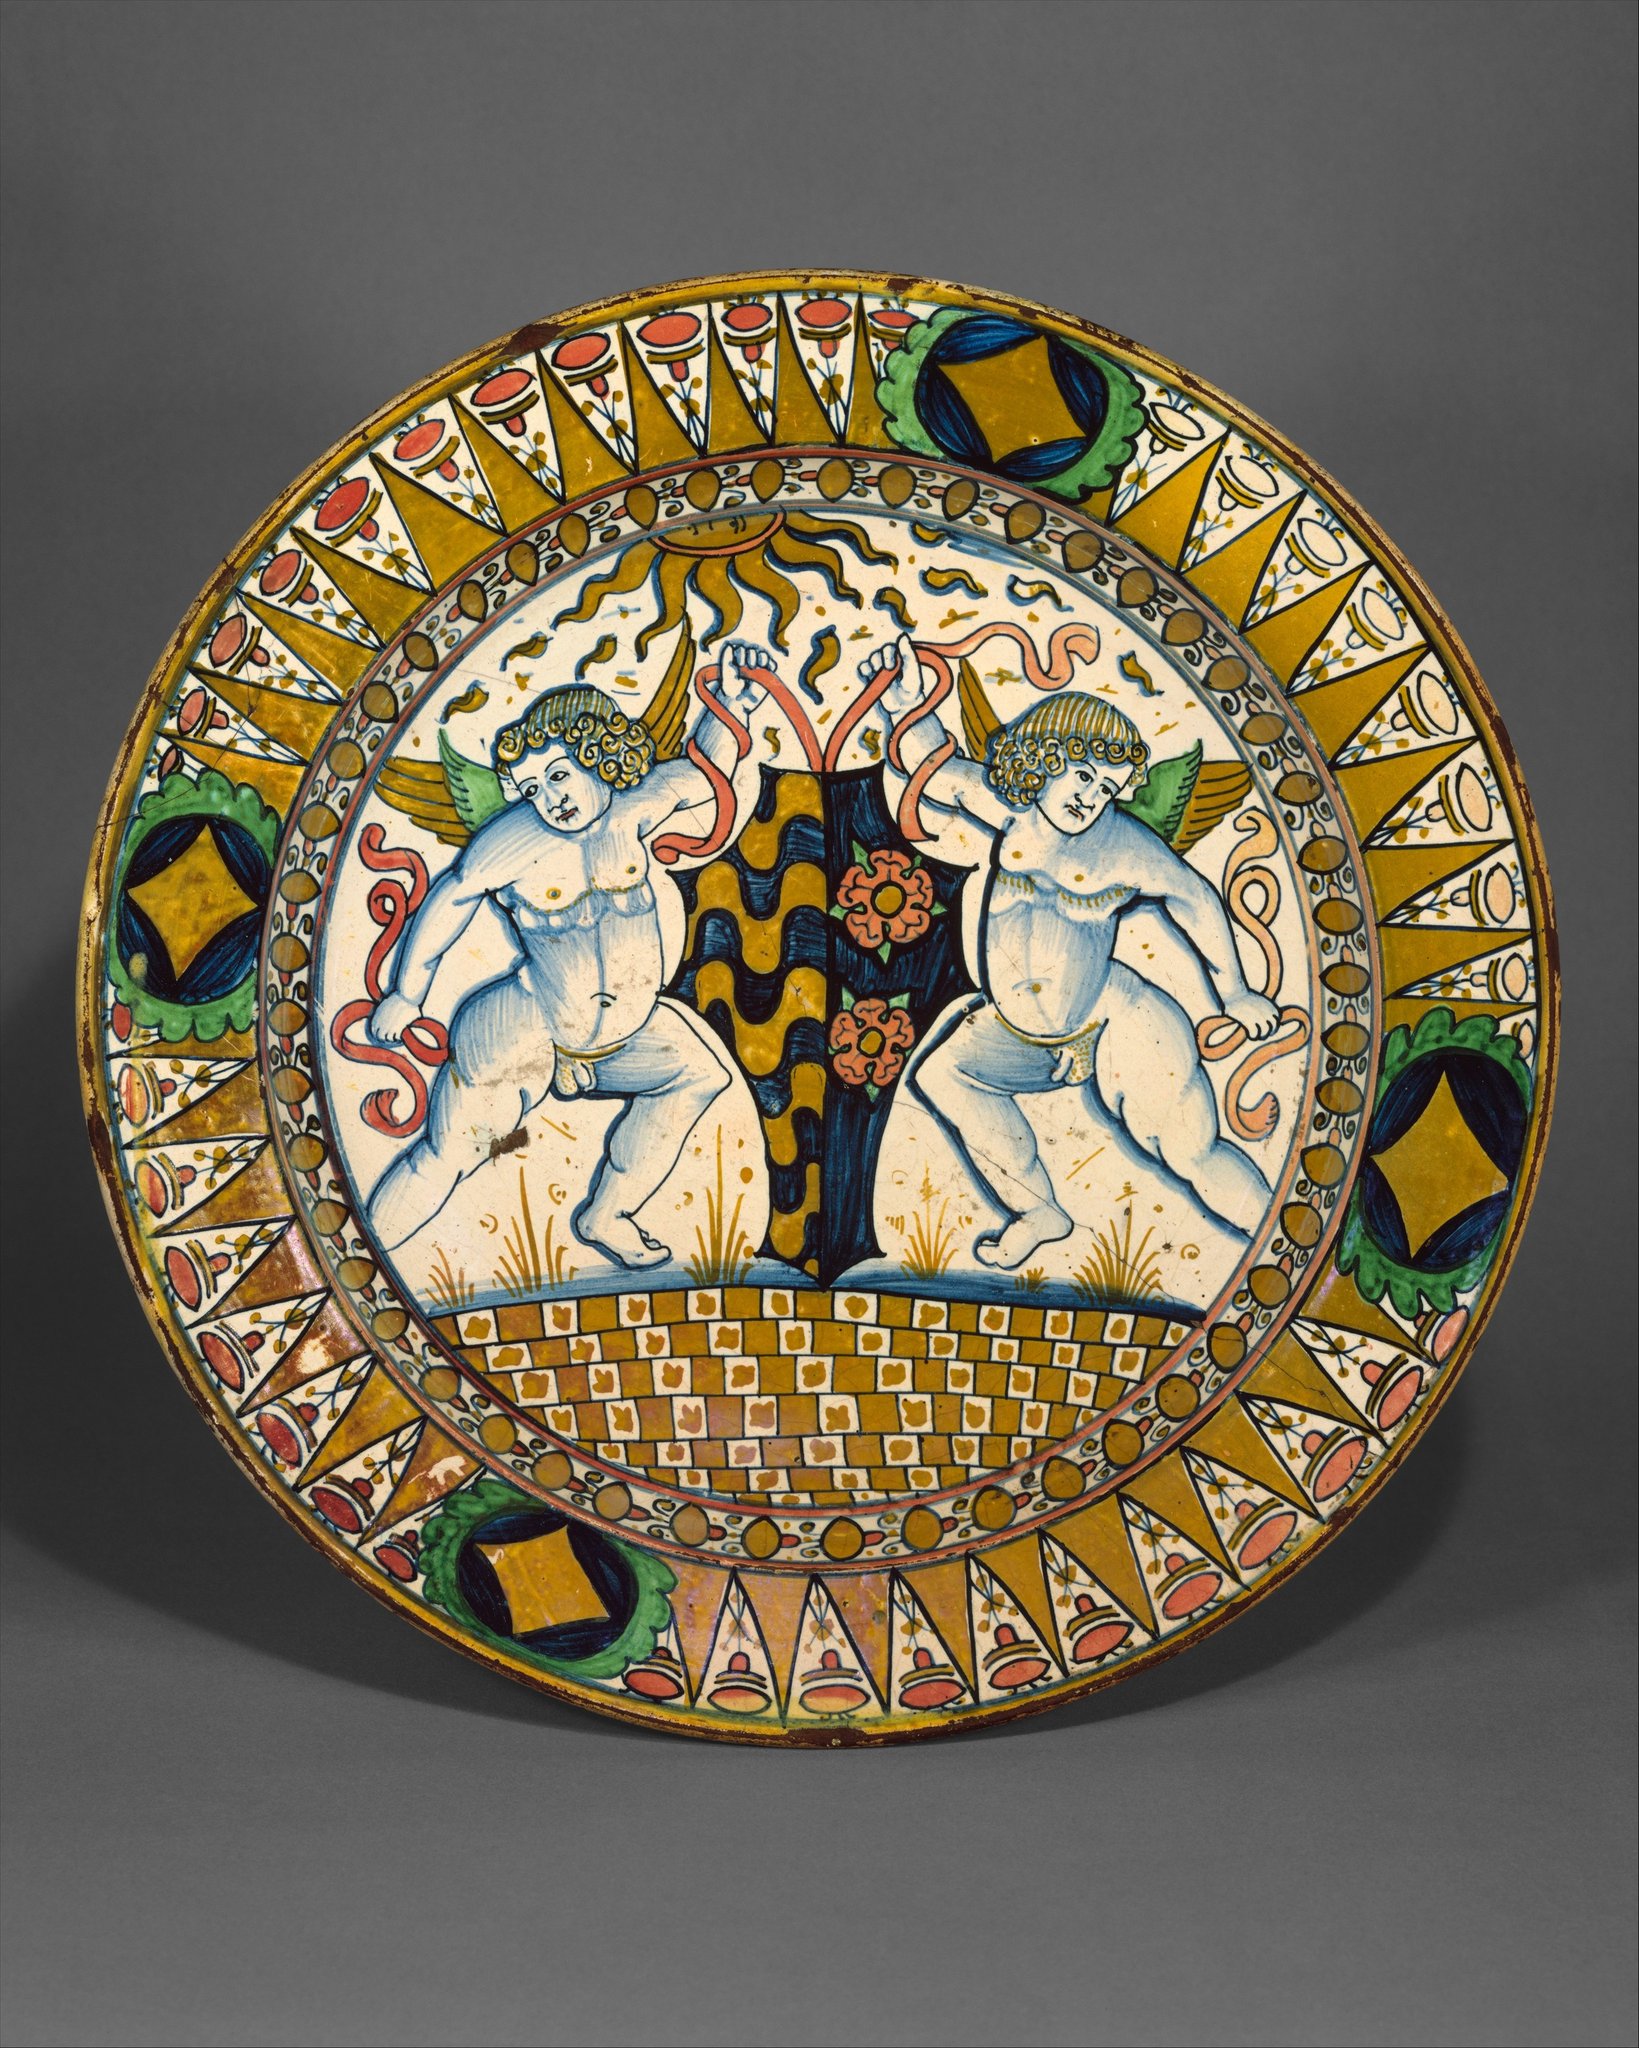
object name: dish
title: Dish (piatto)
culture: italian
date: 1510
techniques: maiolica, glazing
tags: putti